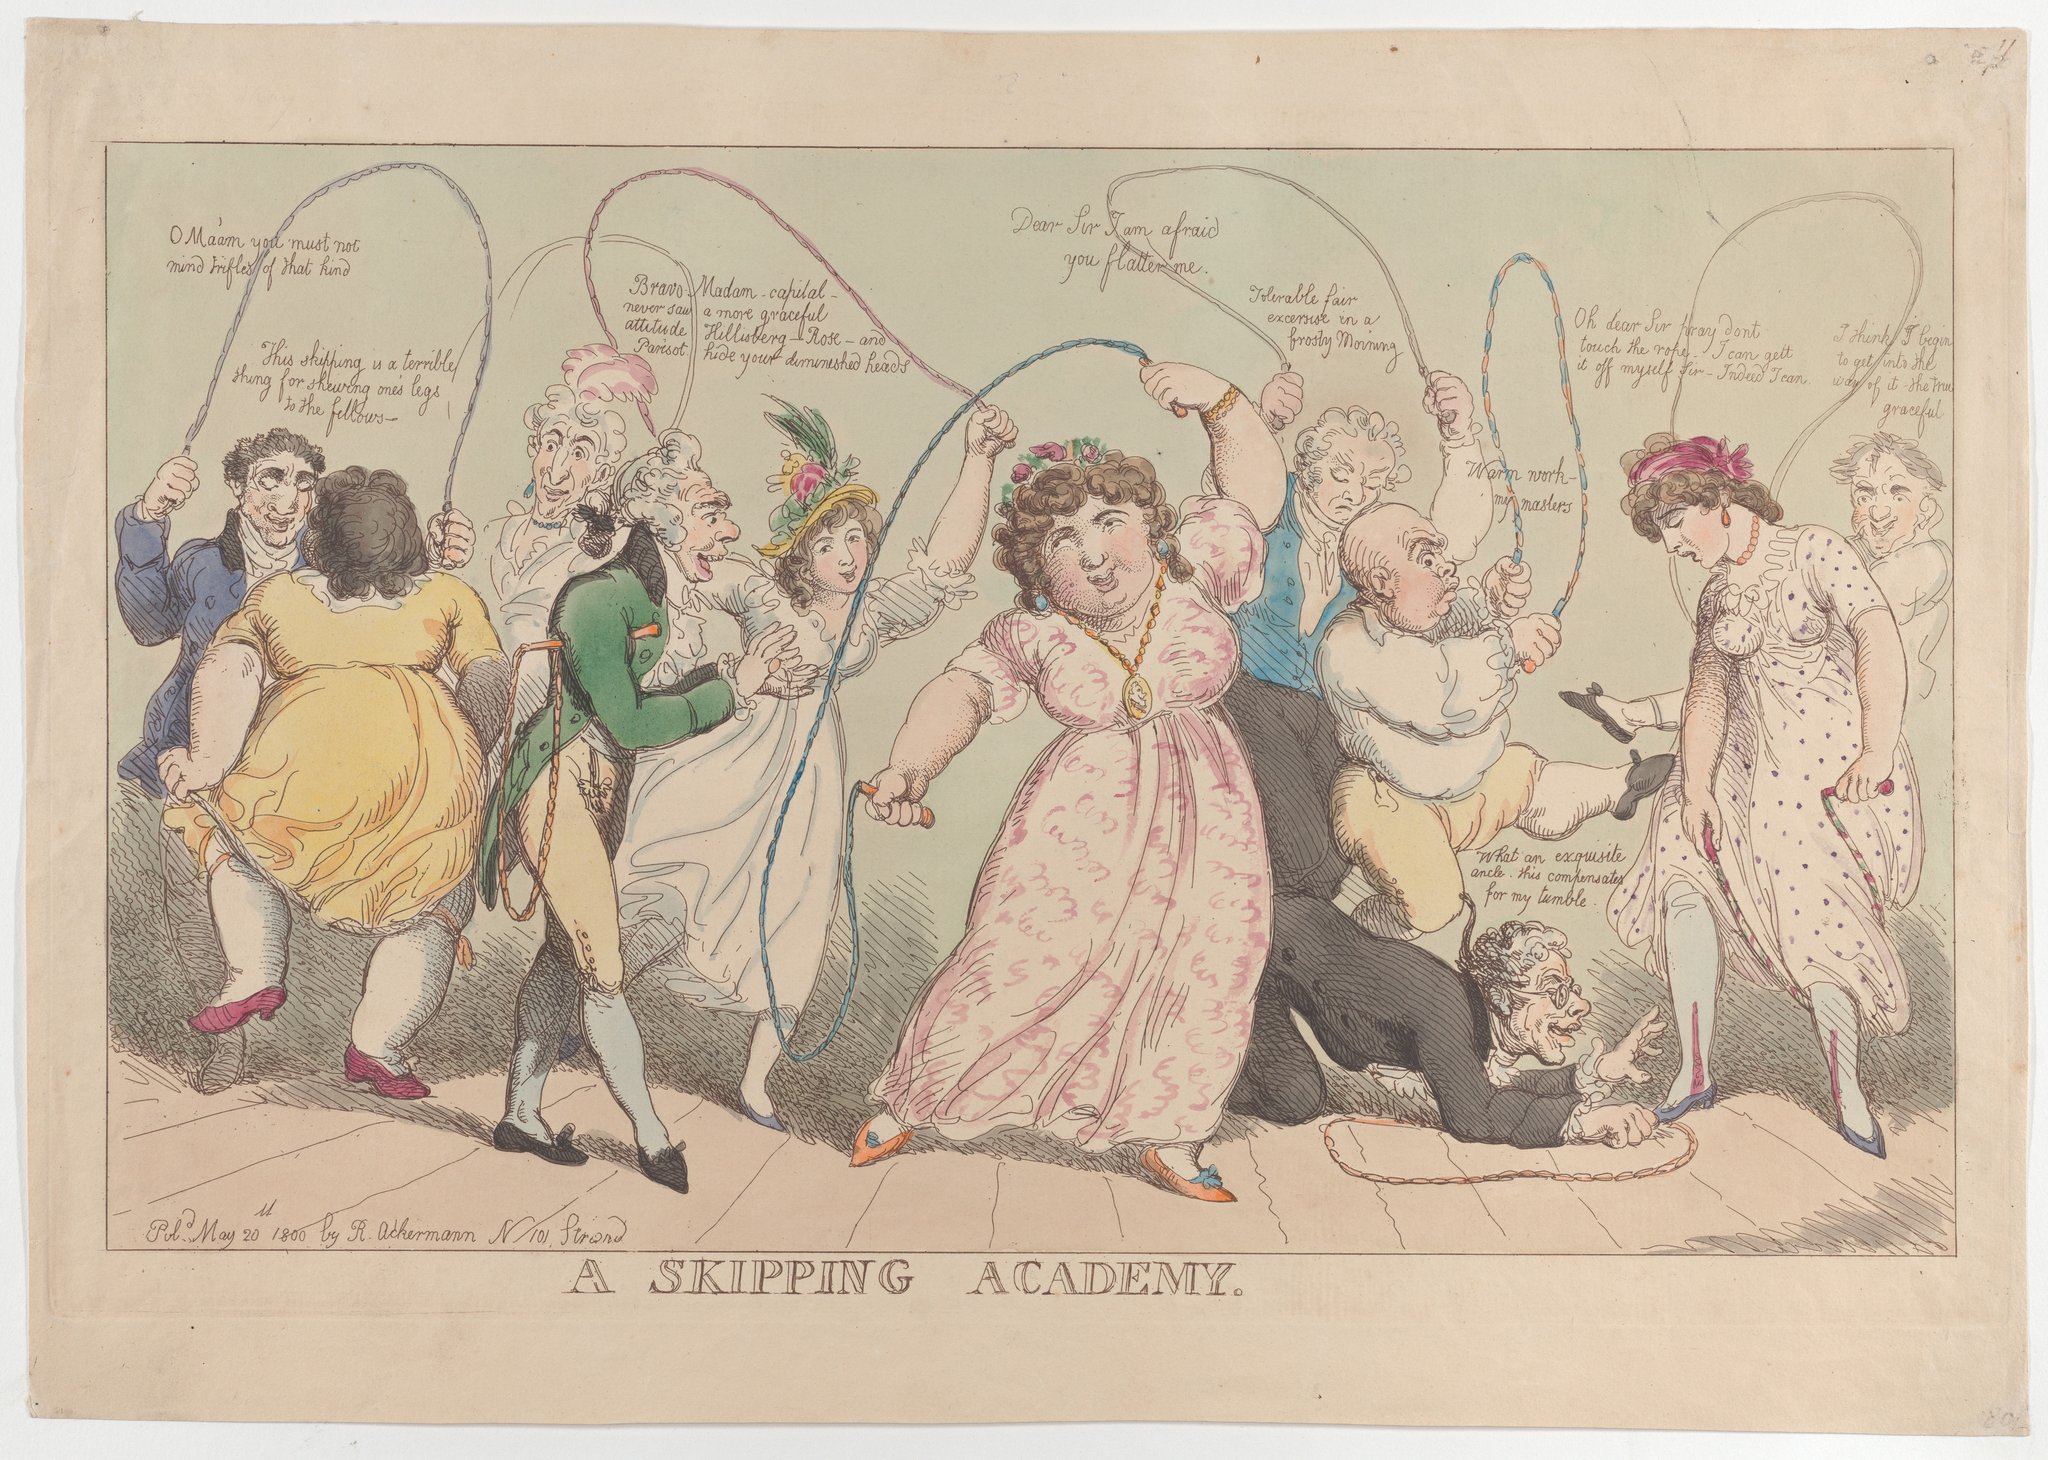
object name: print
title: A Skipping Academy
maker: thomas rowlandson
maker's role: artist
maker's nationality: british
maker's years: 1757-1827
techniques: etching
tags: satire,men,women